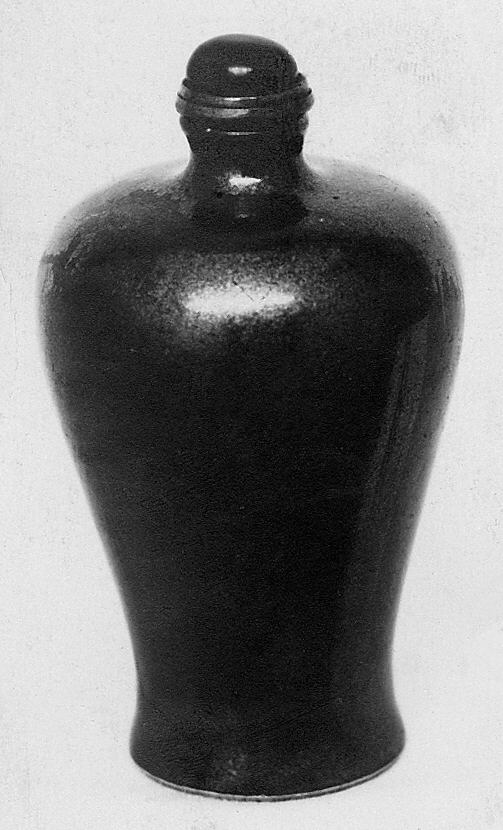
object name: snuff bottle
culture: chinese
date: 1736-1795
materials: porcelain